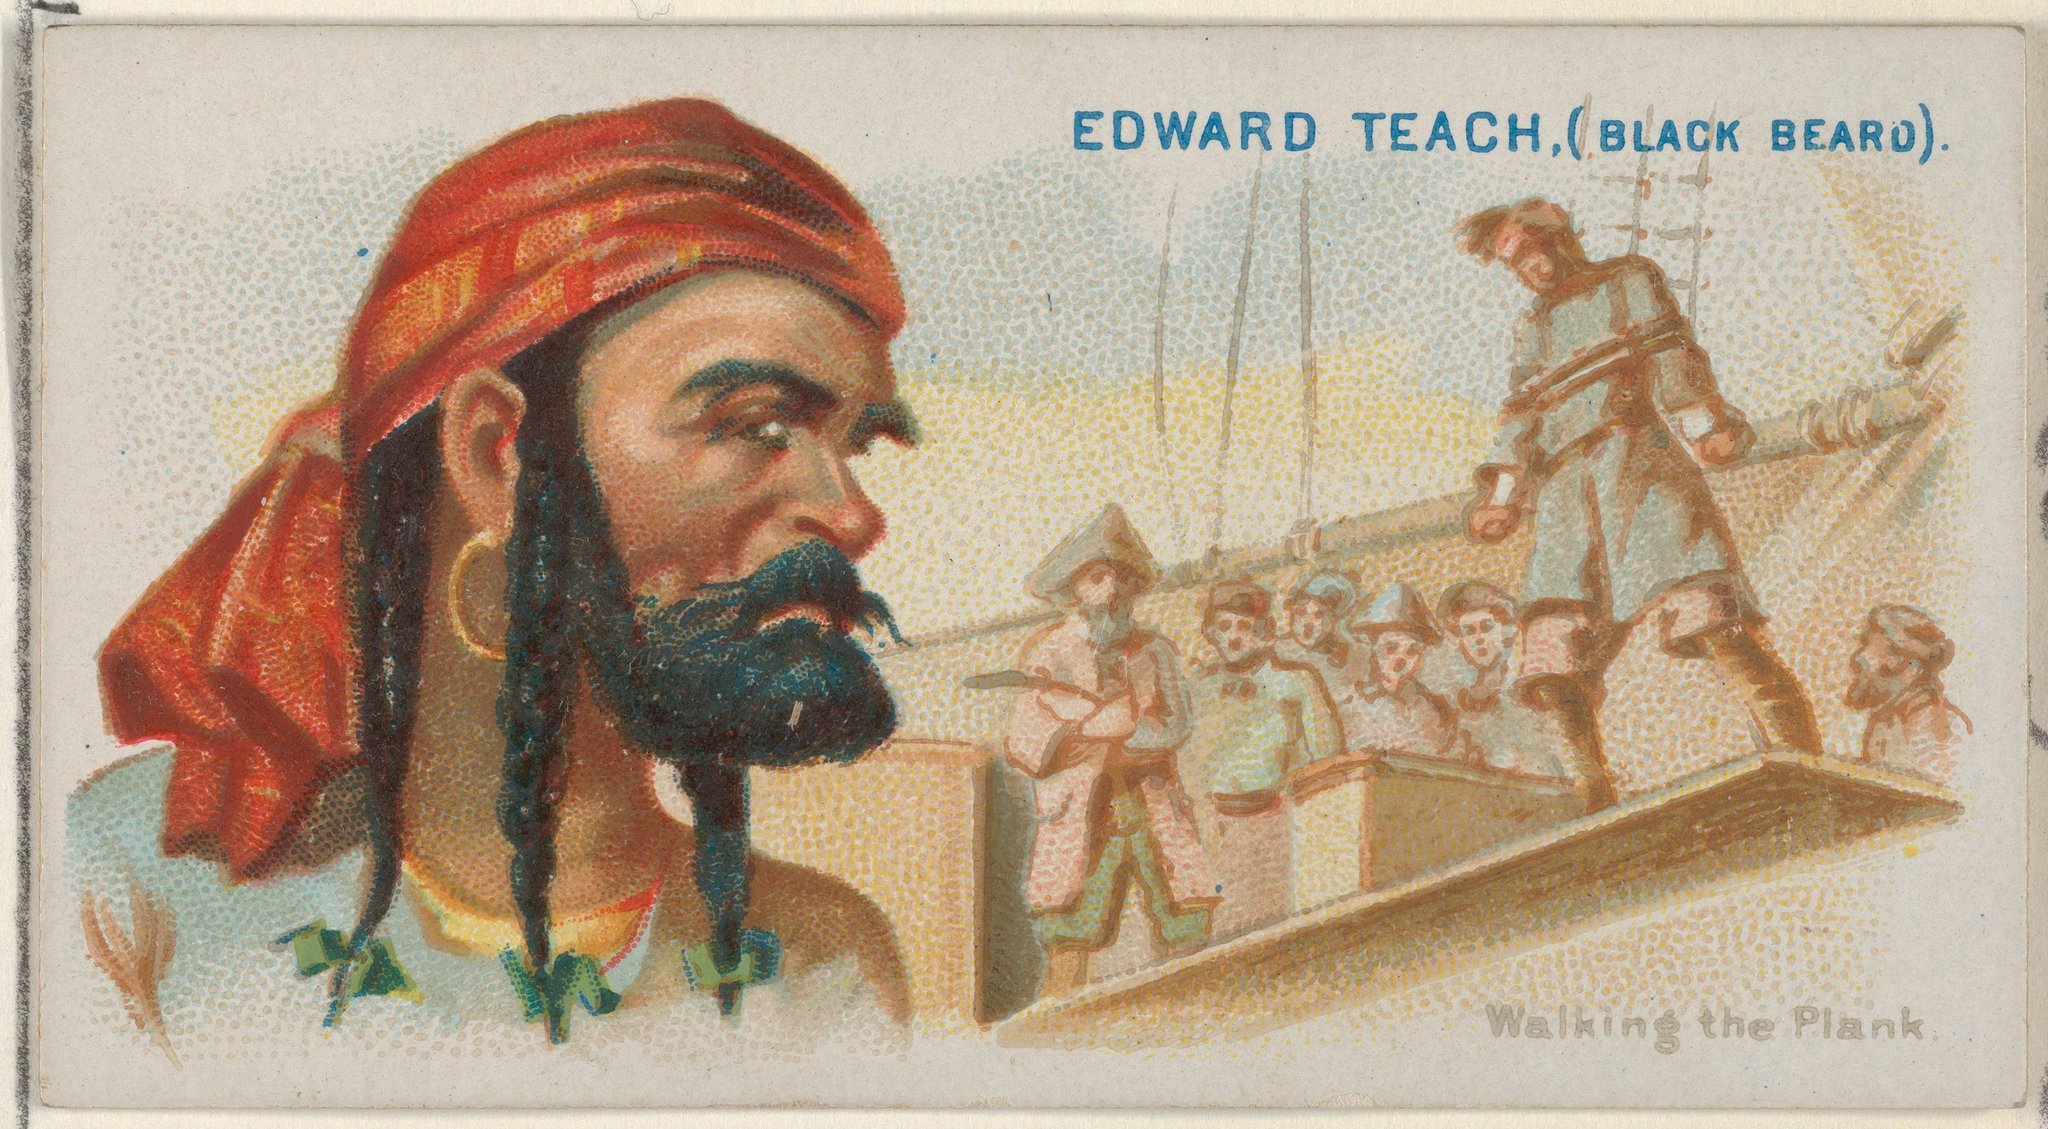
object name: print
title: Edward Teach (Black Beard), Walking the Plank, from the Pirates of the Spanish Main series (N19) for Allen & Ginter Cigarettes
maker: allen & ginter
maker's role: publisher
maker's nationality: american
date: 1888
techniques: color lithograph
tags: men